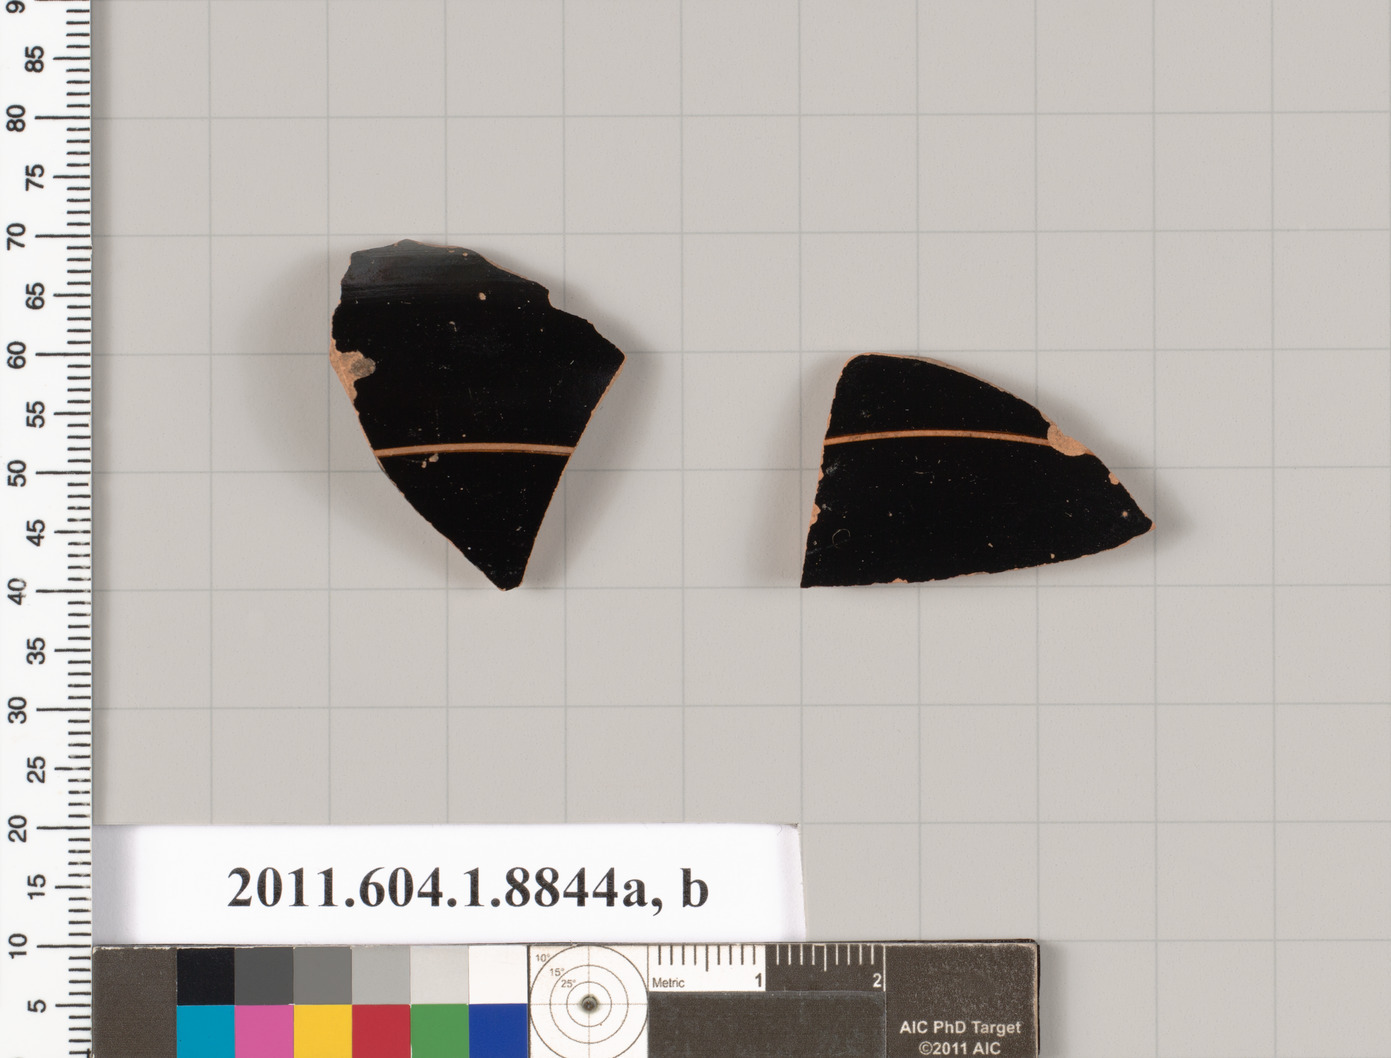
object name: kylix fragment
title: Terracotta fragments of kylikes (drinking cups)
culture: greek, attic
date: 500-470 BCE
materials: terracotta